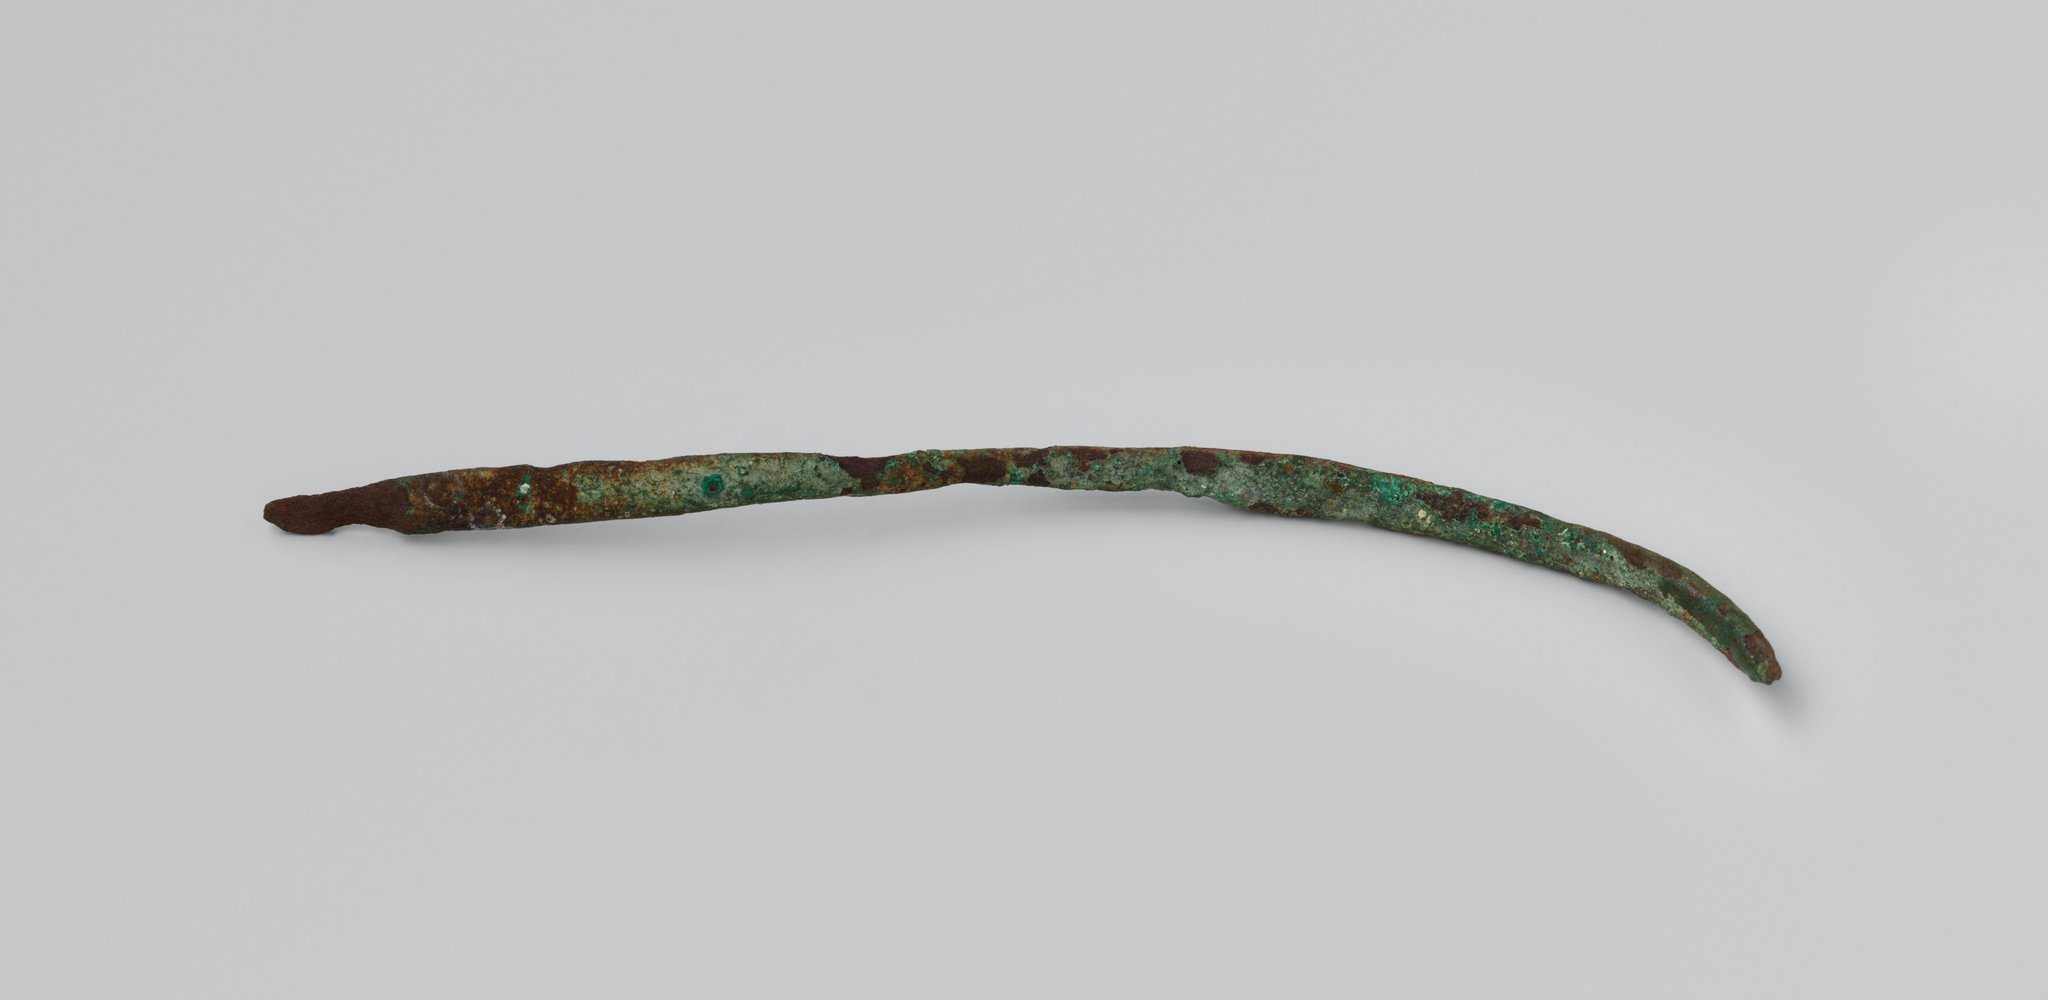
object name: fragment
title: Fragment of onderdeel uit het wrak van de Oost-Indiëvaarder Hollandia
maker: Anonymous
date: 1743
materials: copper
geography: netherlands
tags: verenigde oostindische compagnie, hollandia (schip), annet